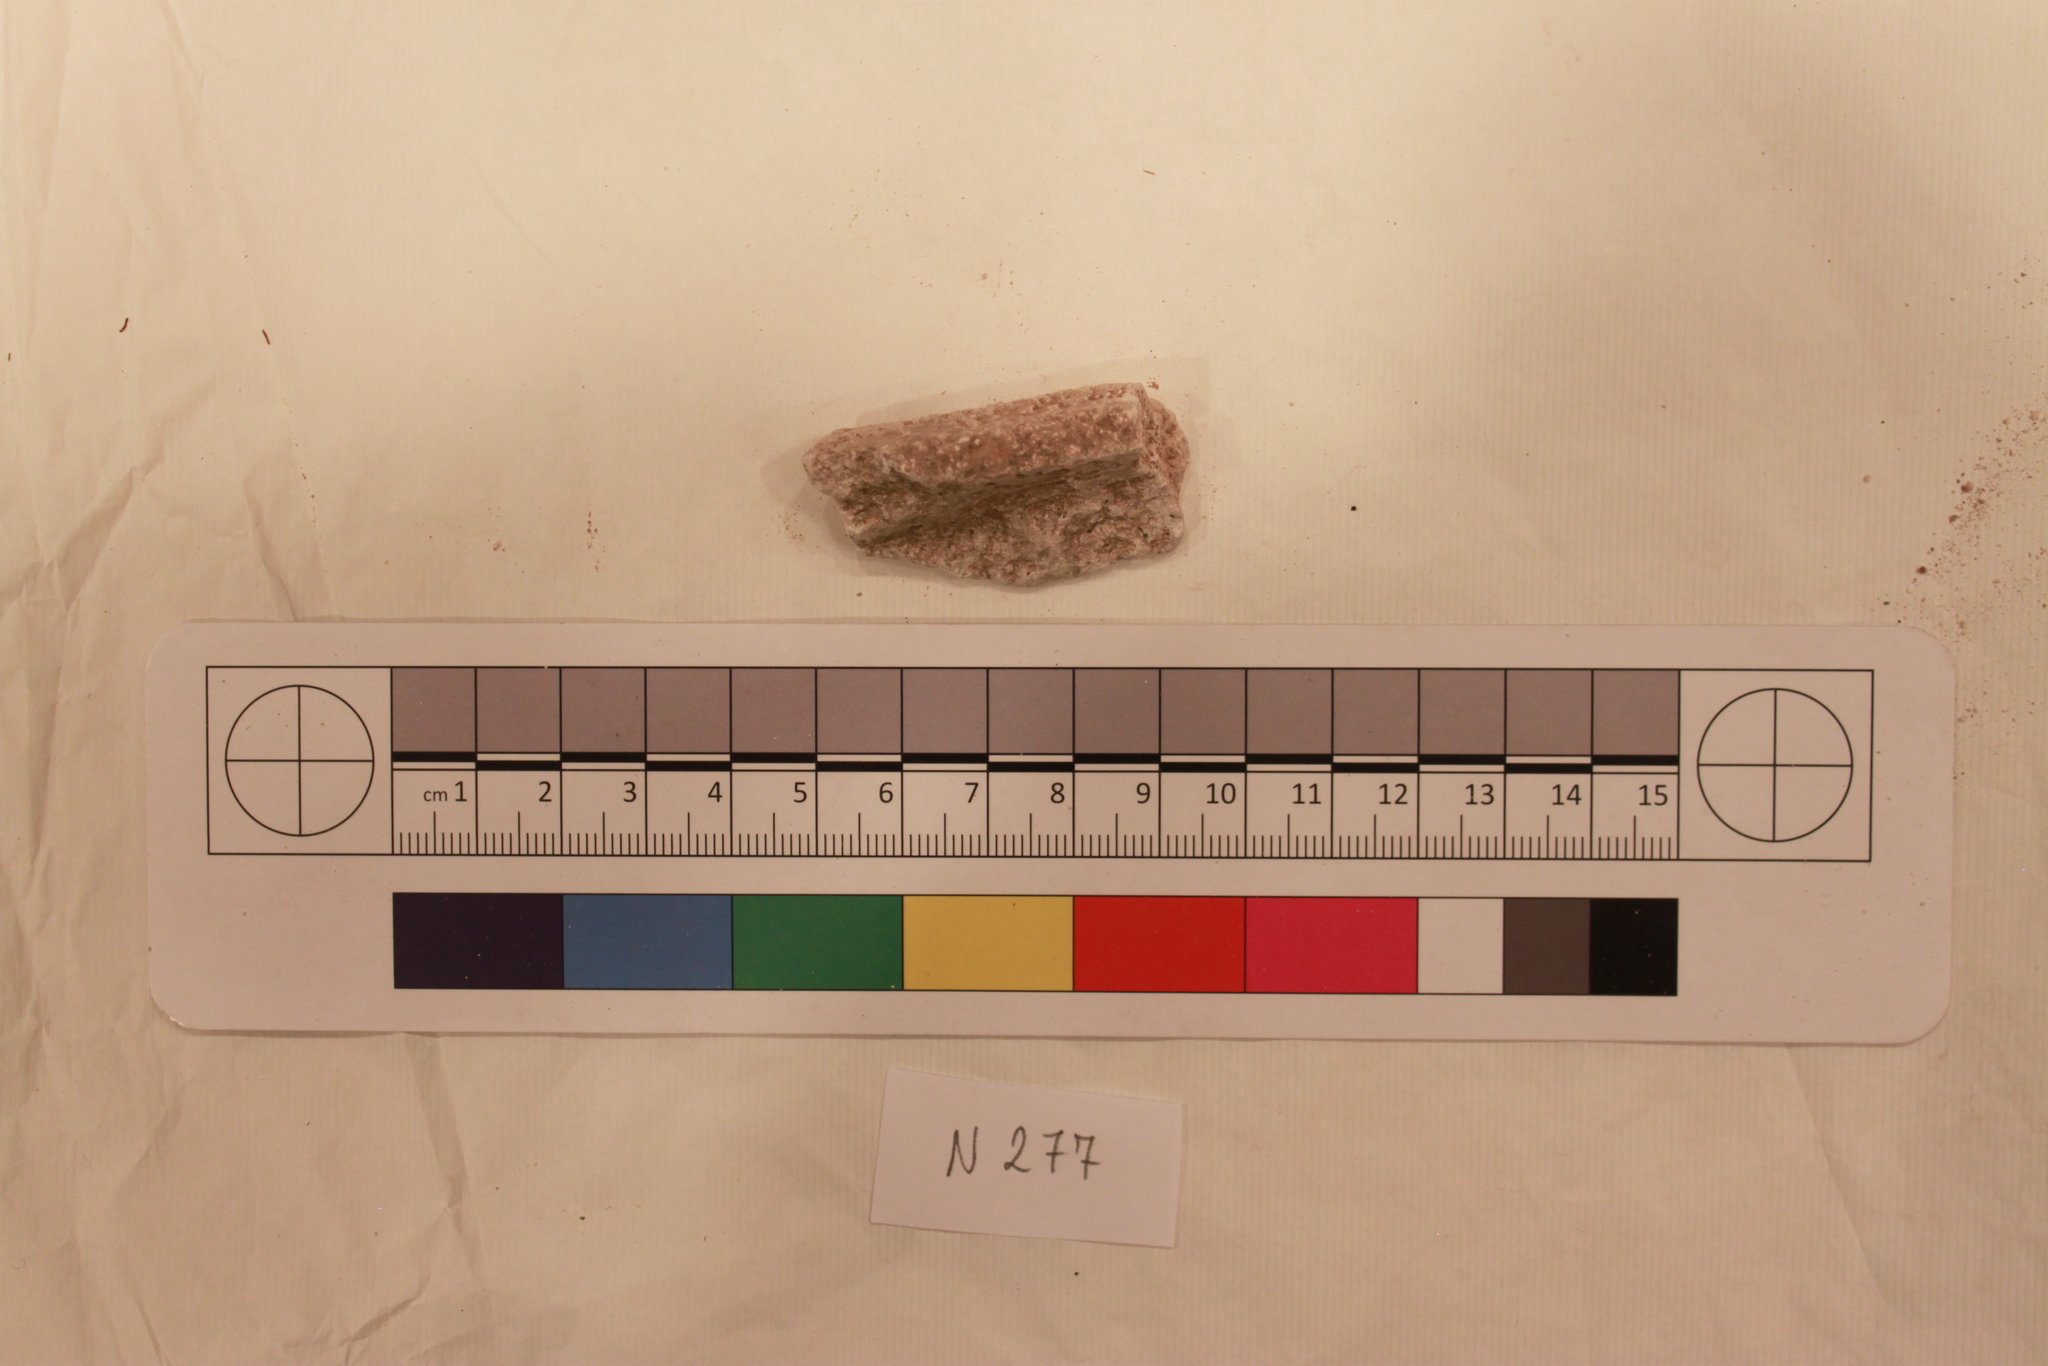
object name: fragment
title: Stucco Fragment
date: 701-1200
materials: plaster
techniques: carving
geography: iran